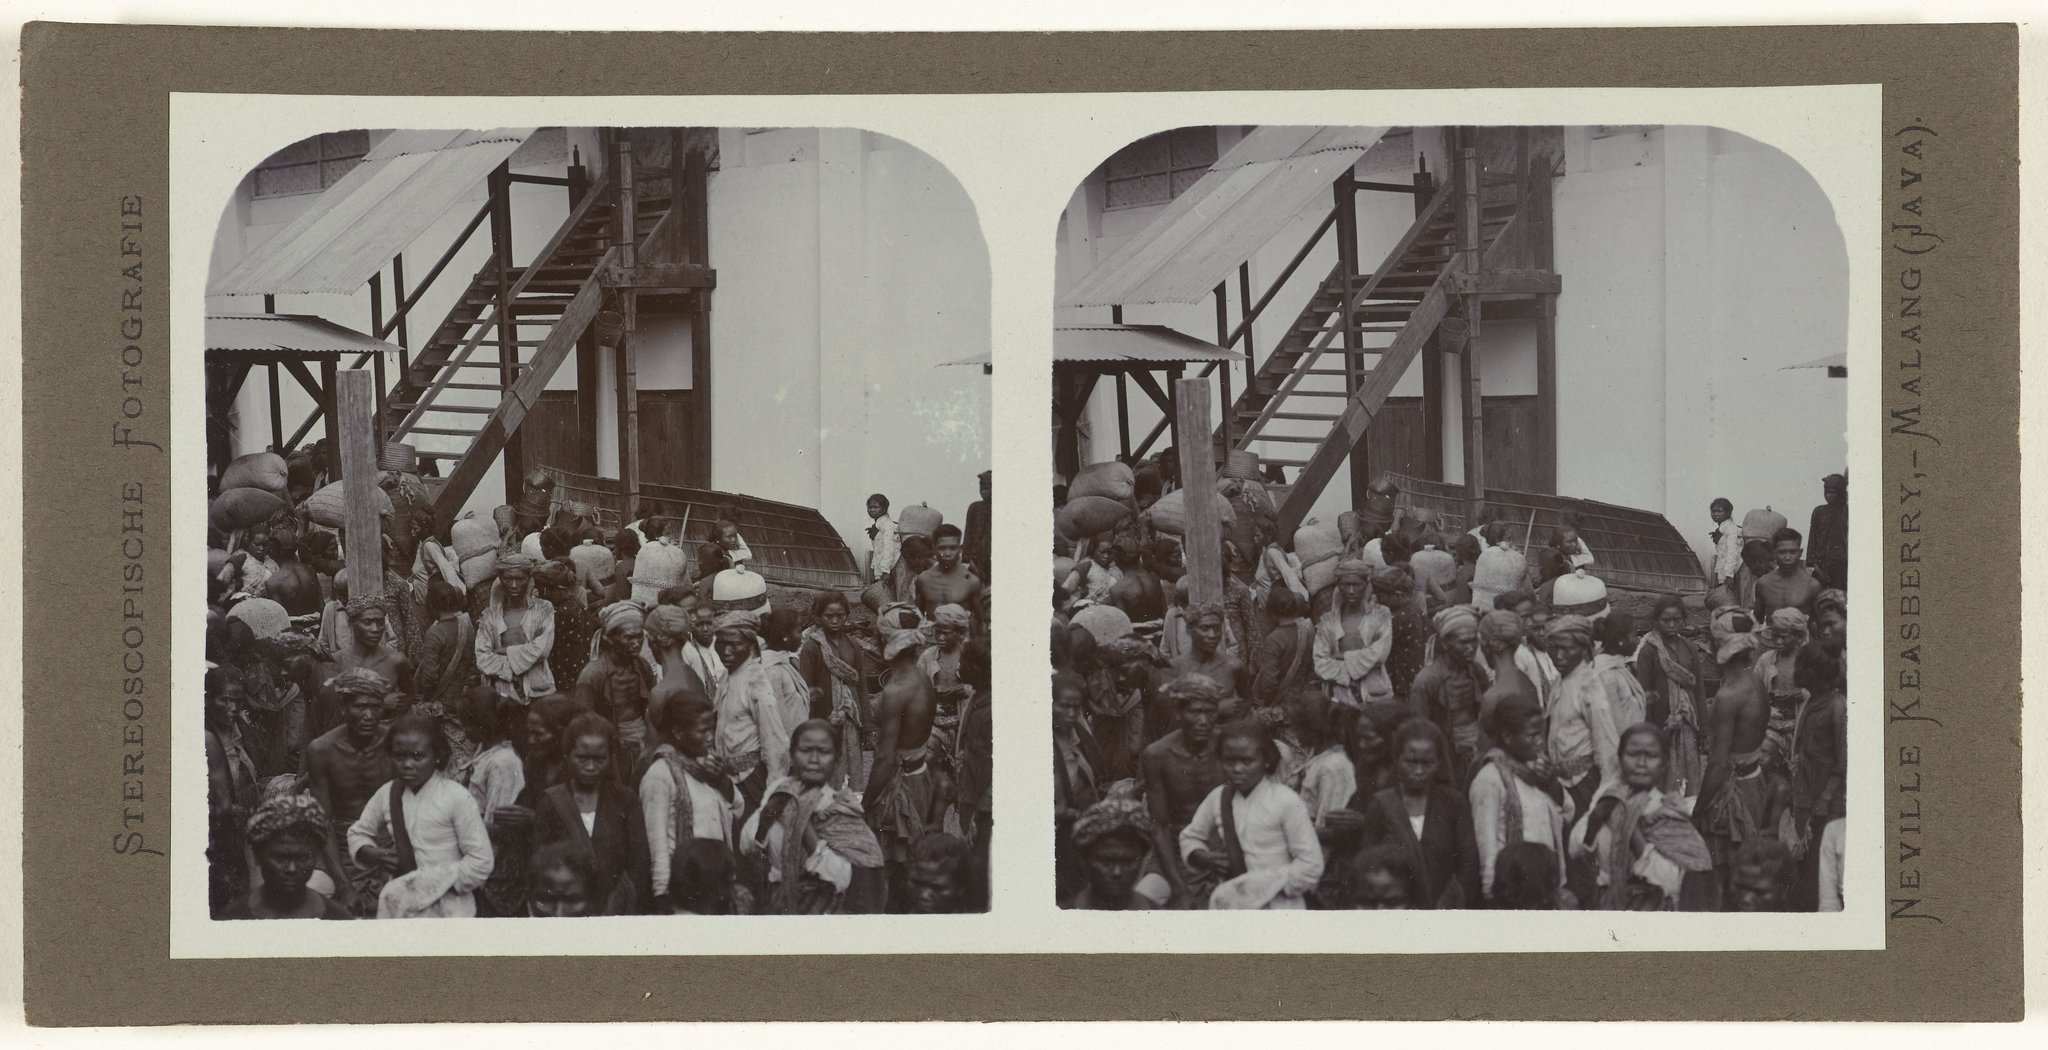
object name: stereograph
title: Het binnenbrengen van de koffiepluk in grote zakken op de rug door Javaanse werknemers.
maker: neville keasberry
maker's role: fotograaf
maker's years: 1866-1944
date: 1900-1935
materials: cardboard, paper, photographic support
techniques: albumen print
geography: malang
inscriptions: inscription: ‘Stereoscopische Fotografie’, signature: ‘Neville Keasberry, Malang (Java)’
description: Javaanse eettentjes in de buitenlucht op een druk bezocht terrein.